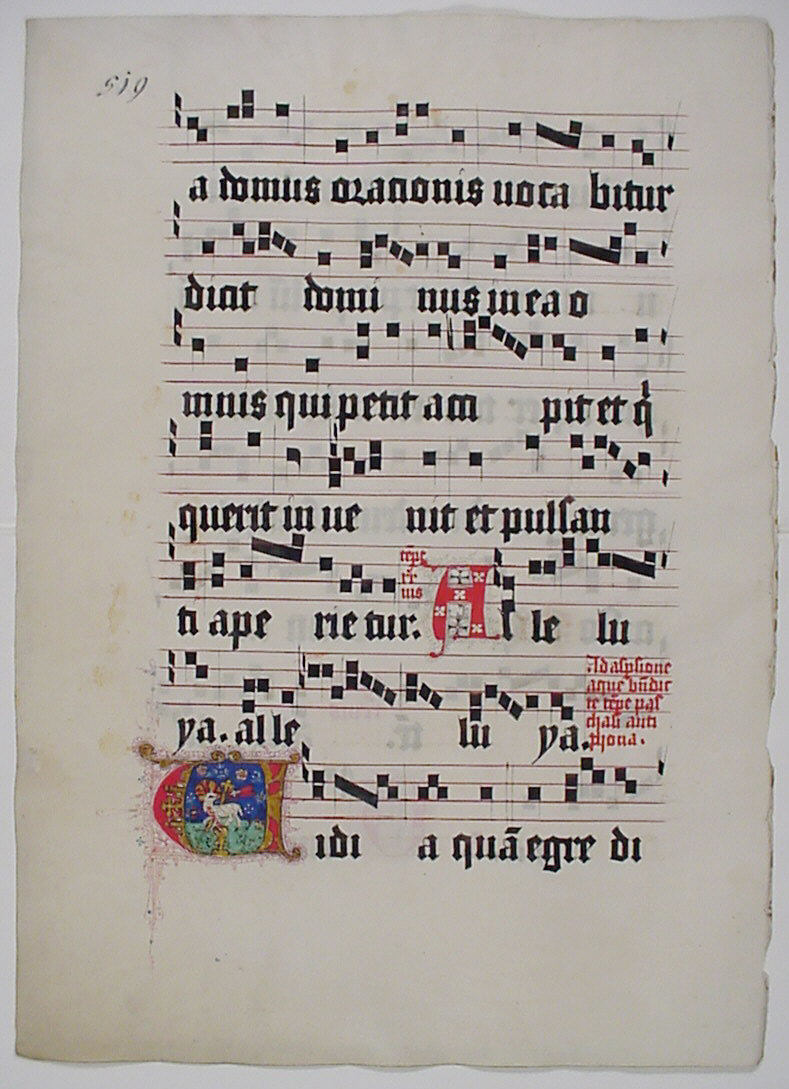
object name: gradual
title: Manuscript Leaf with Initial V, from a Gradual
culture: german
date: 1426-1450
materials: ink, metal leaf, parchment, paint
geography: germany